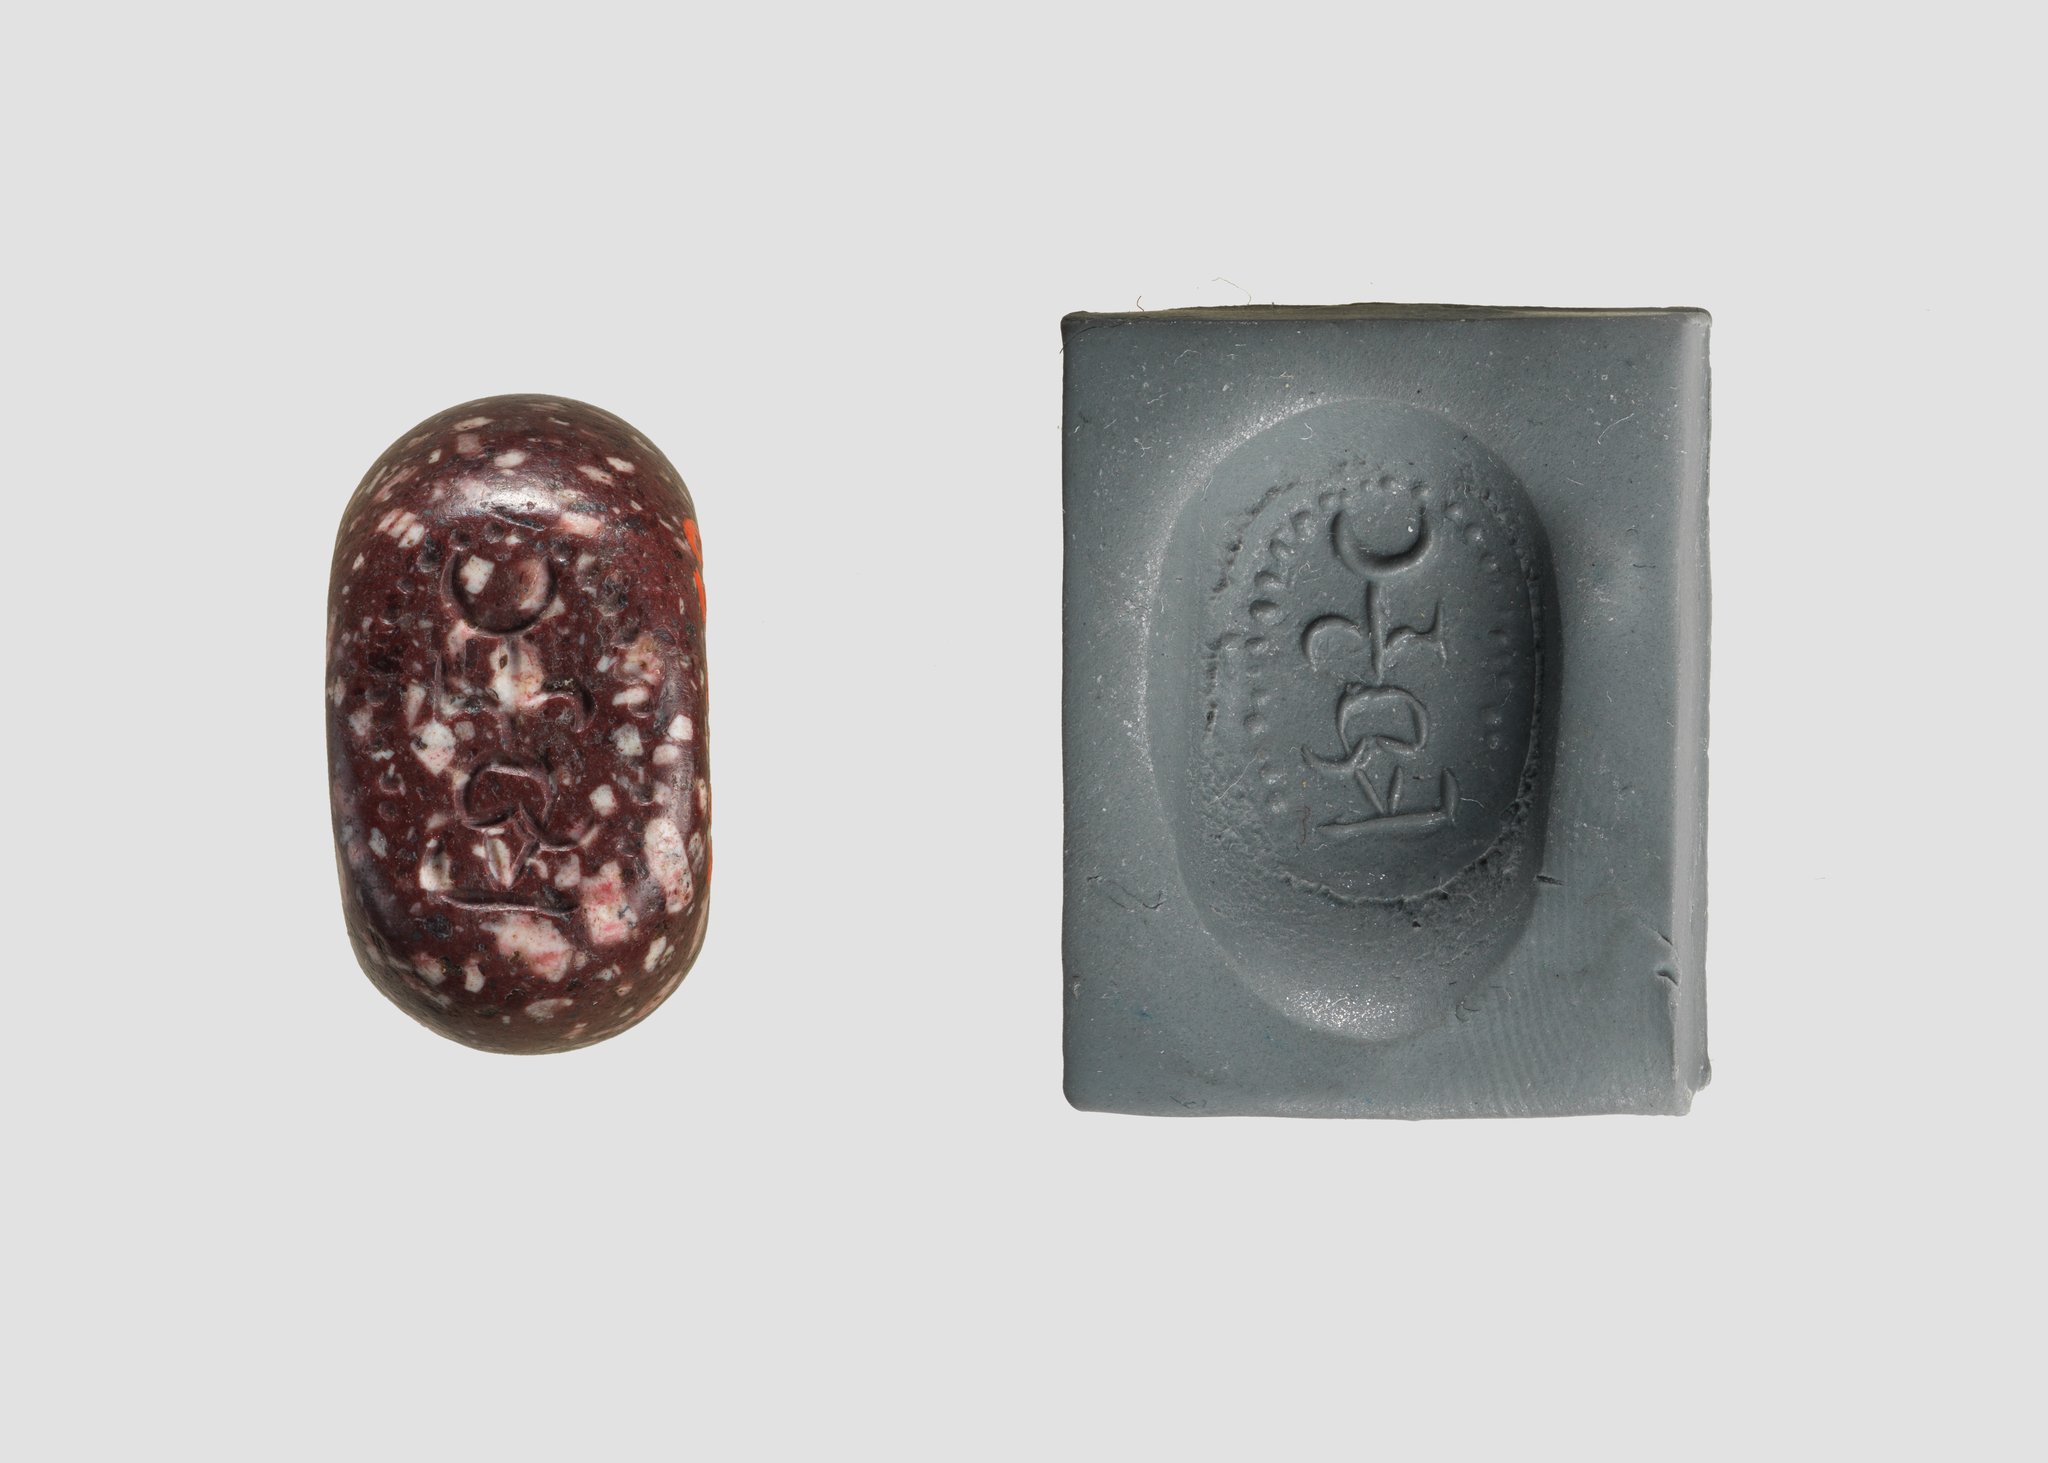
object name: stamp seal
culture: sasanian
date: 201-700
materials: marble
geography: iran or mesopotamia